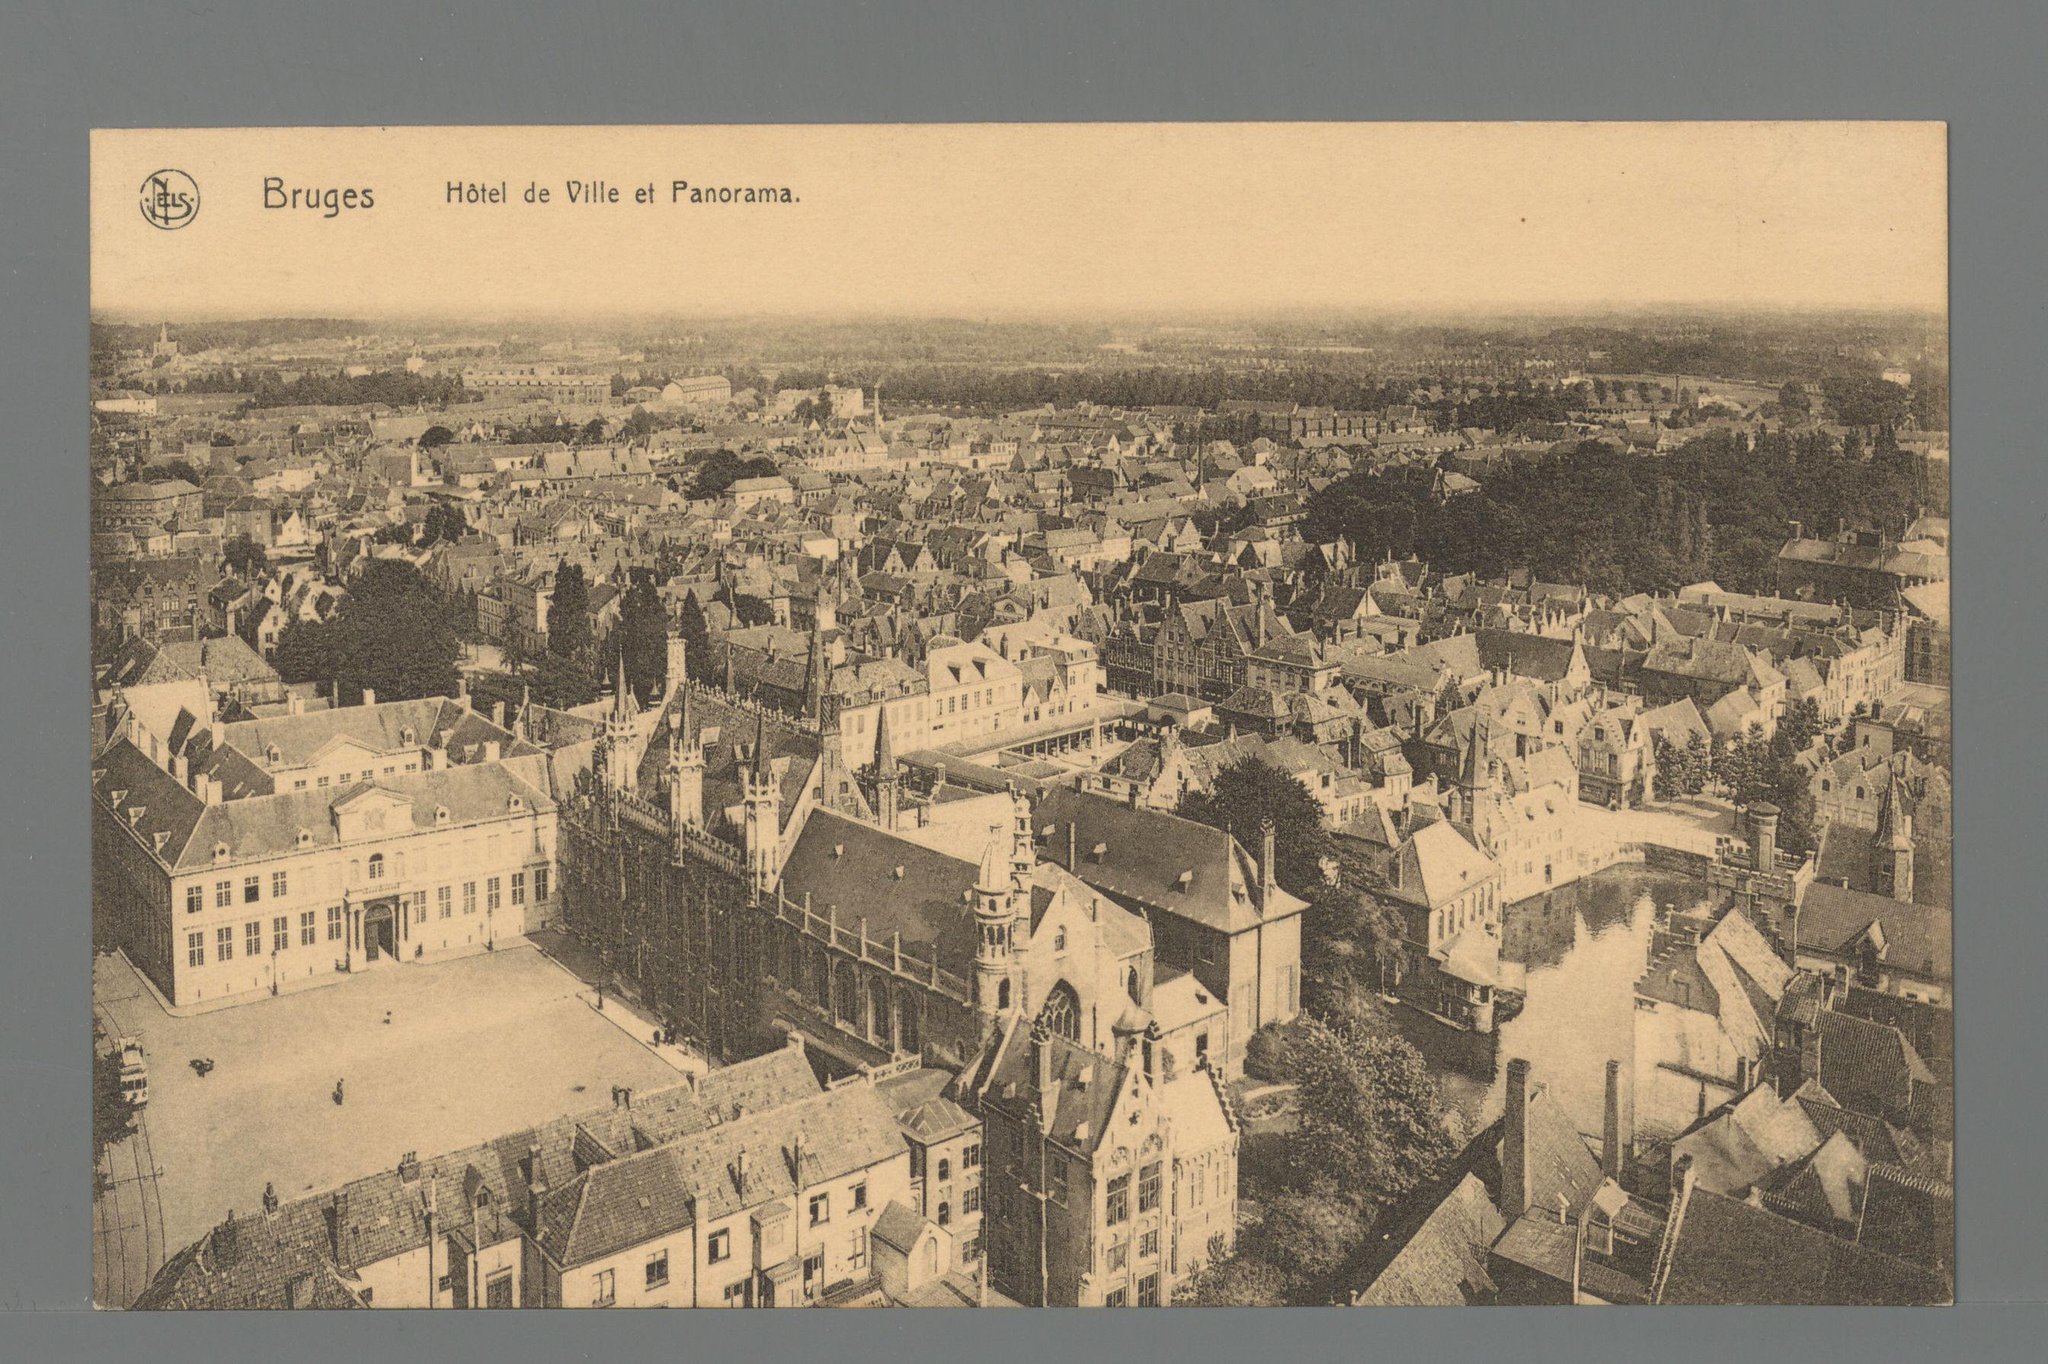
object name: photomechanical print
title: Bruges. Hôtel de Ville et Panorama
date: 1913-1930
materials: cardboard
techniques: photograph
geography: brussels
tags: square, place, circus, etc., townhall, prospect of city, town panorama, silhouette of city, bruges